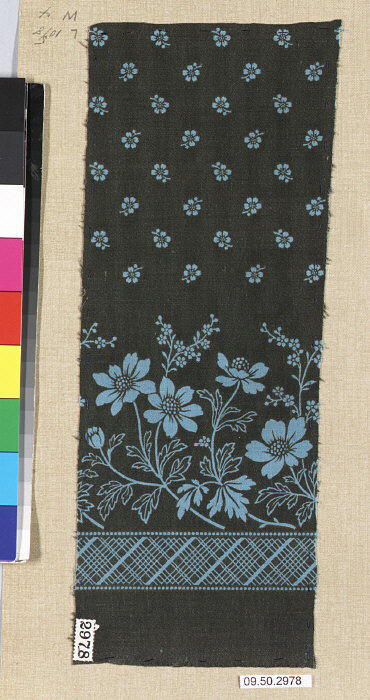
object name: piece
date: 1801-1900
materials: cotton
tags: flowers,leaves